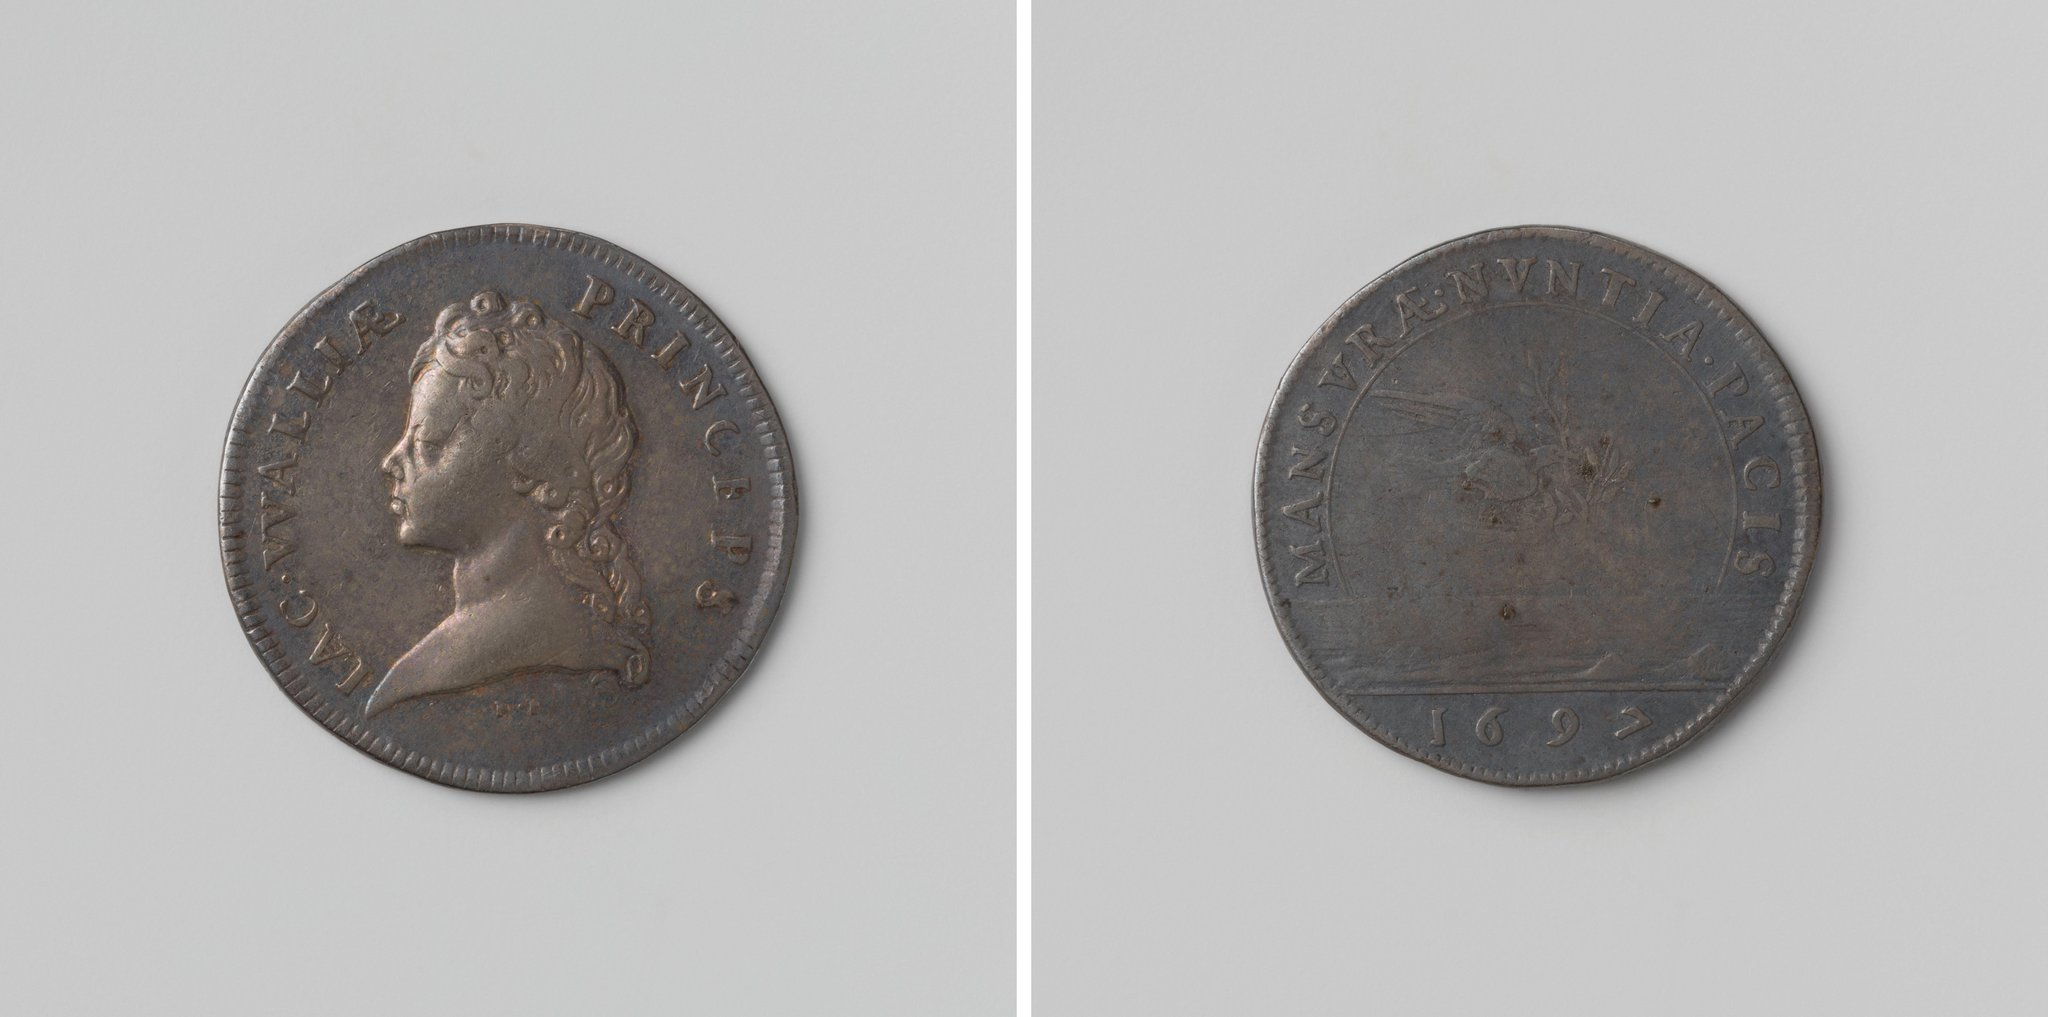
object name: jeton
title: Jacobus, prins van Wales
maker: norbert roëttiers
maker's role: medailleur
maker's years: 1666-1727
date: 1697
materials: silver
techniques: striking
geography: france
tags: london, rome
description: Zilveren penning. Voorzijde: borststuk man binnen omschrift. Keerzijde: duif met olijftak in bek, vliegend boven kalme zee binnen omschrift; afsnede: jaartal